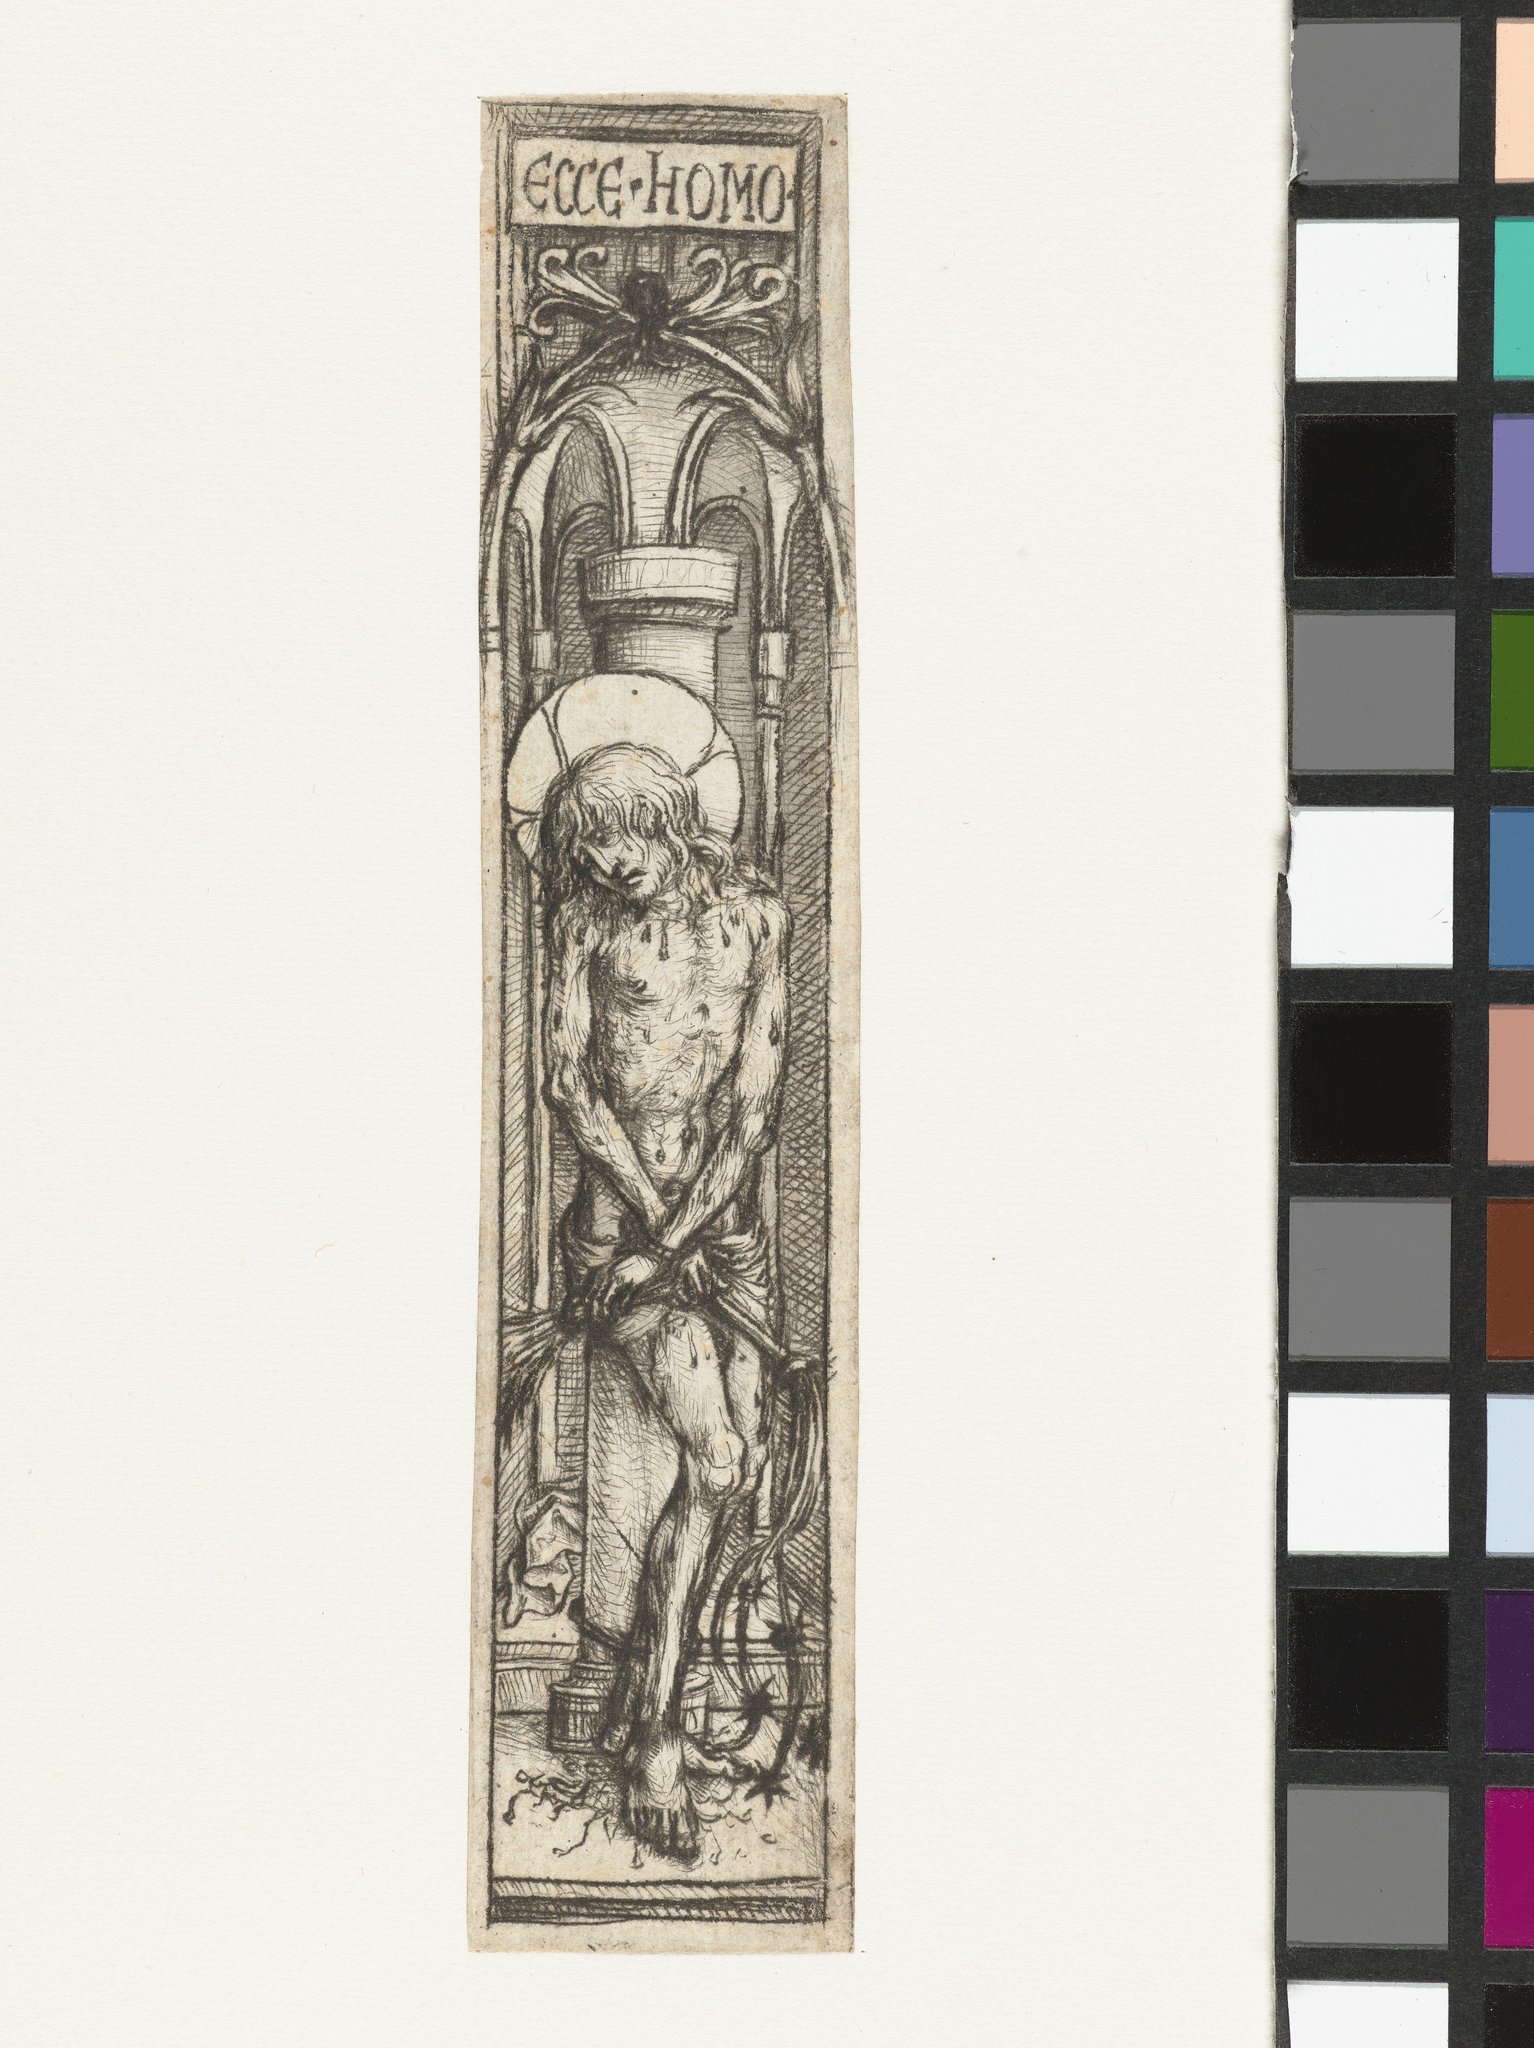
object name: print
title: Ecce Homo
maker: meester van het amsterdamse kabinet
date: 1488-1492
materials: paper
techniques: drypoint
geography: germany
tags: christ on the whipping-post (after the flagellation), christ alone (also called 'ecce homo')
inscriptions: collector's mark: Lugt 2228a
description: Christus staand aan de geselpaal met roede en gesel in zijn handen.